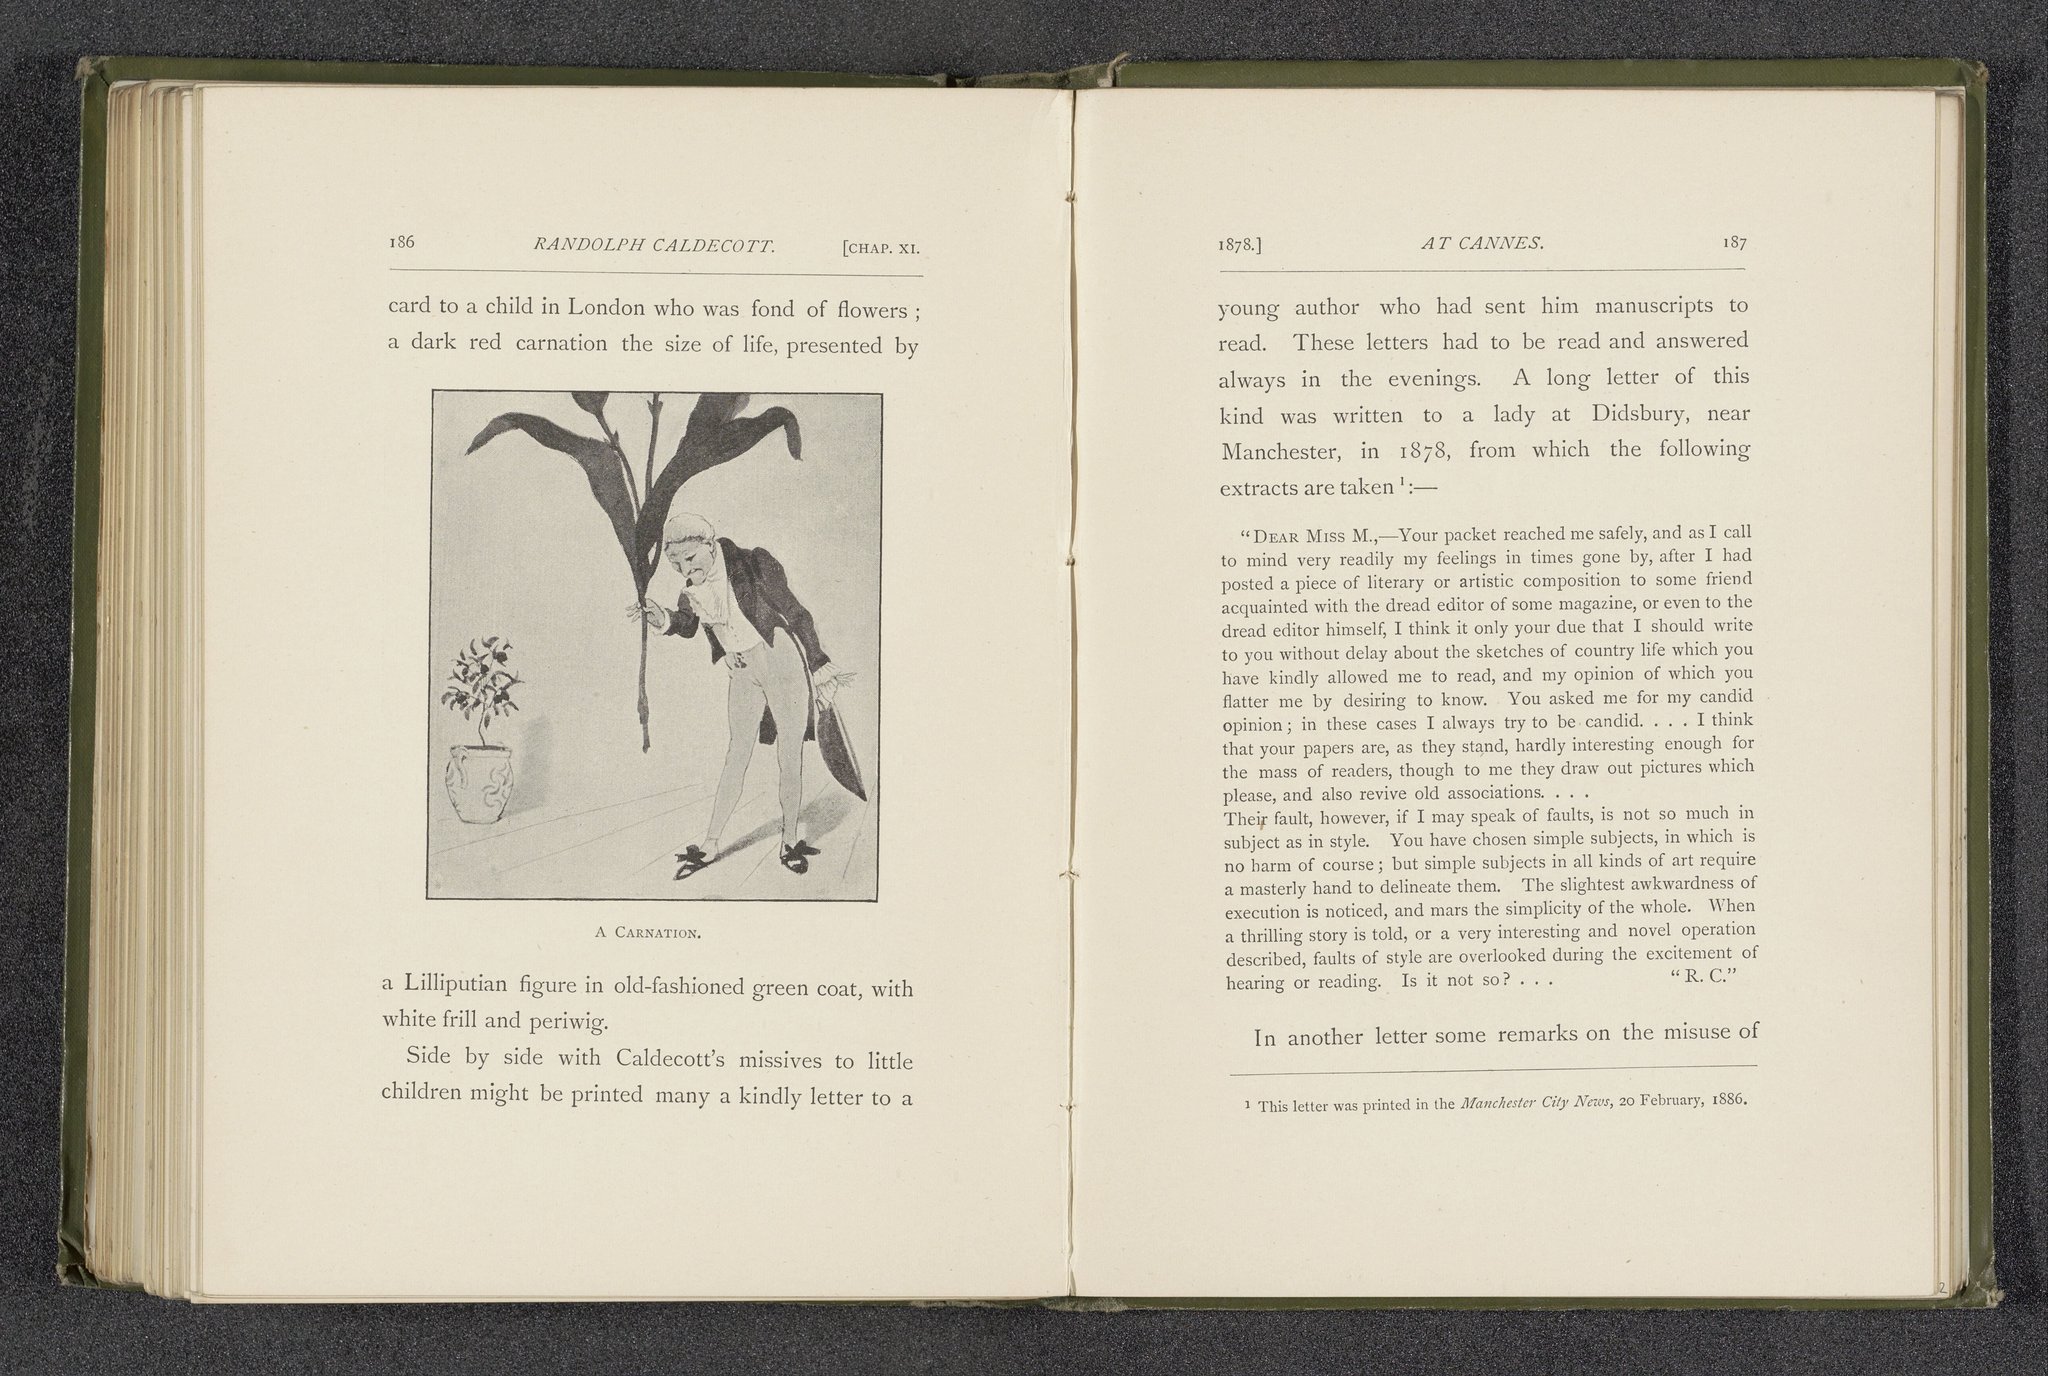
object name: page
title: Fotoreproductie van een verjaardagskaart door Randolph Caldecott, voortellend een man met een grote anjer in zijn hand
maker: Anonymous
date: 1877-1887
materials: paper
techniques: autotype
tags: flowers: carnation